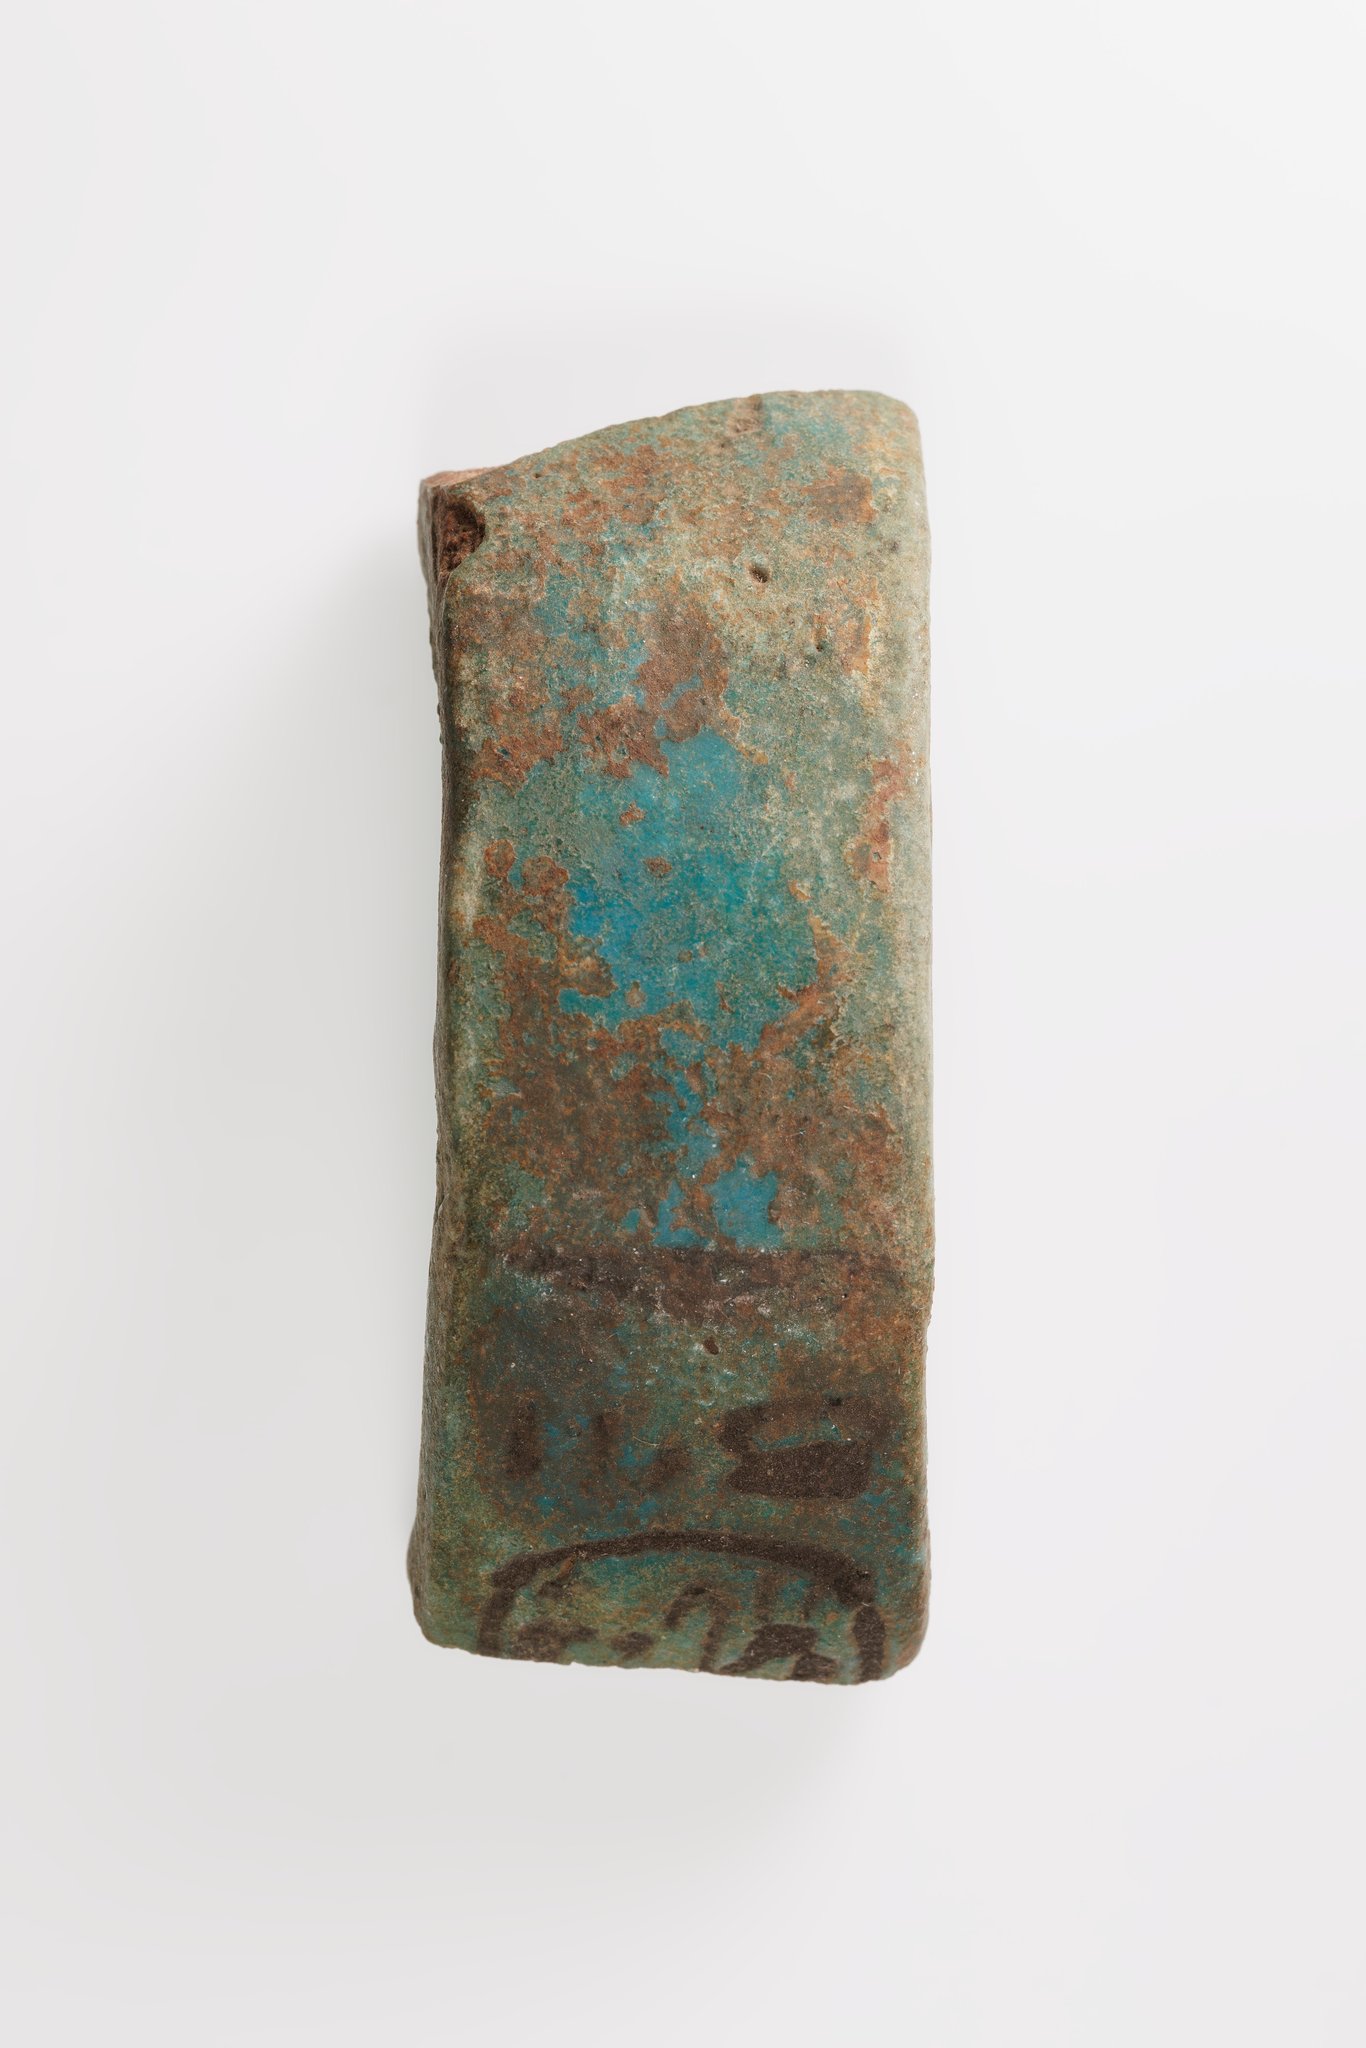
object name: votive bracelet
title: Fragment of a votive bracelet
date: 1295-1070 BCE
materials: faience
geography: egypt